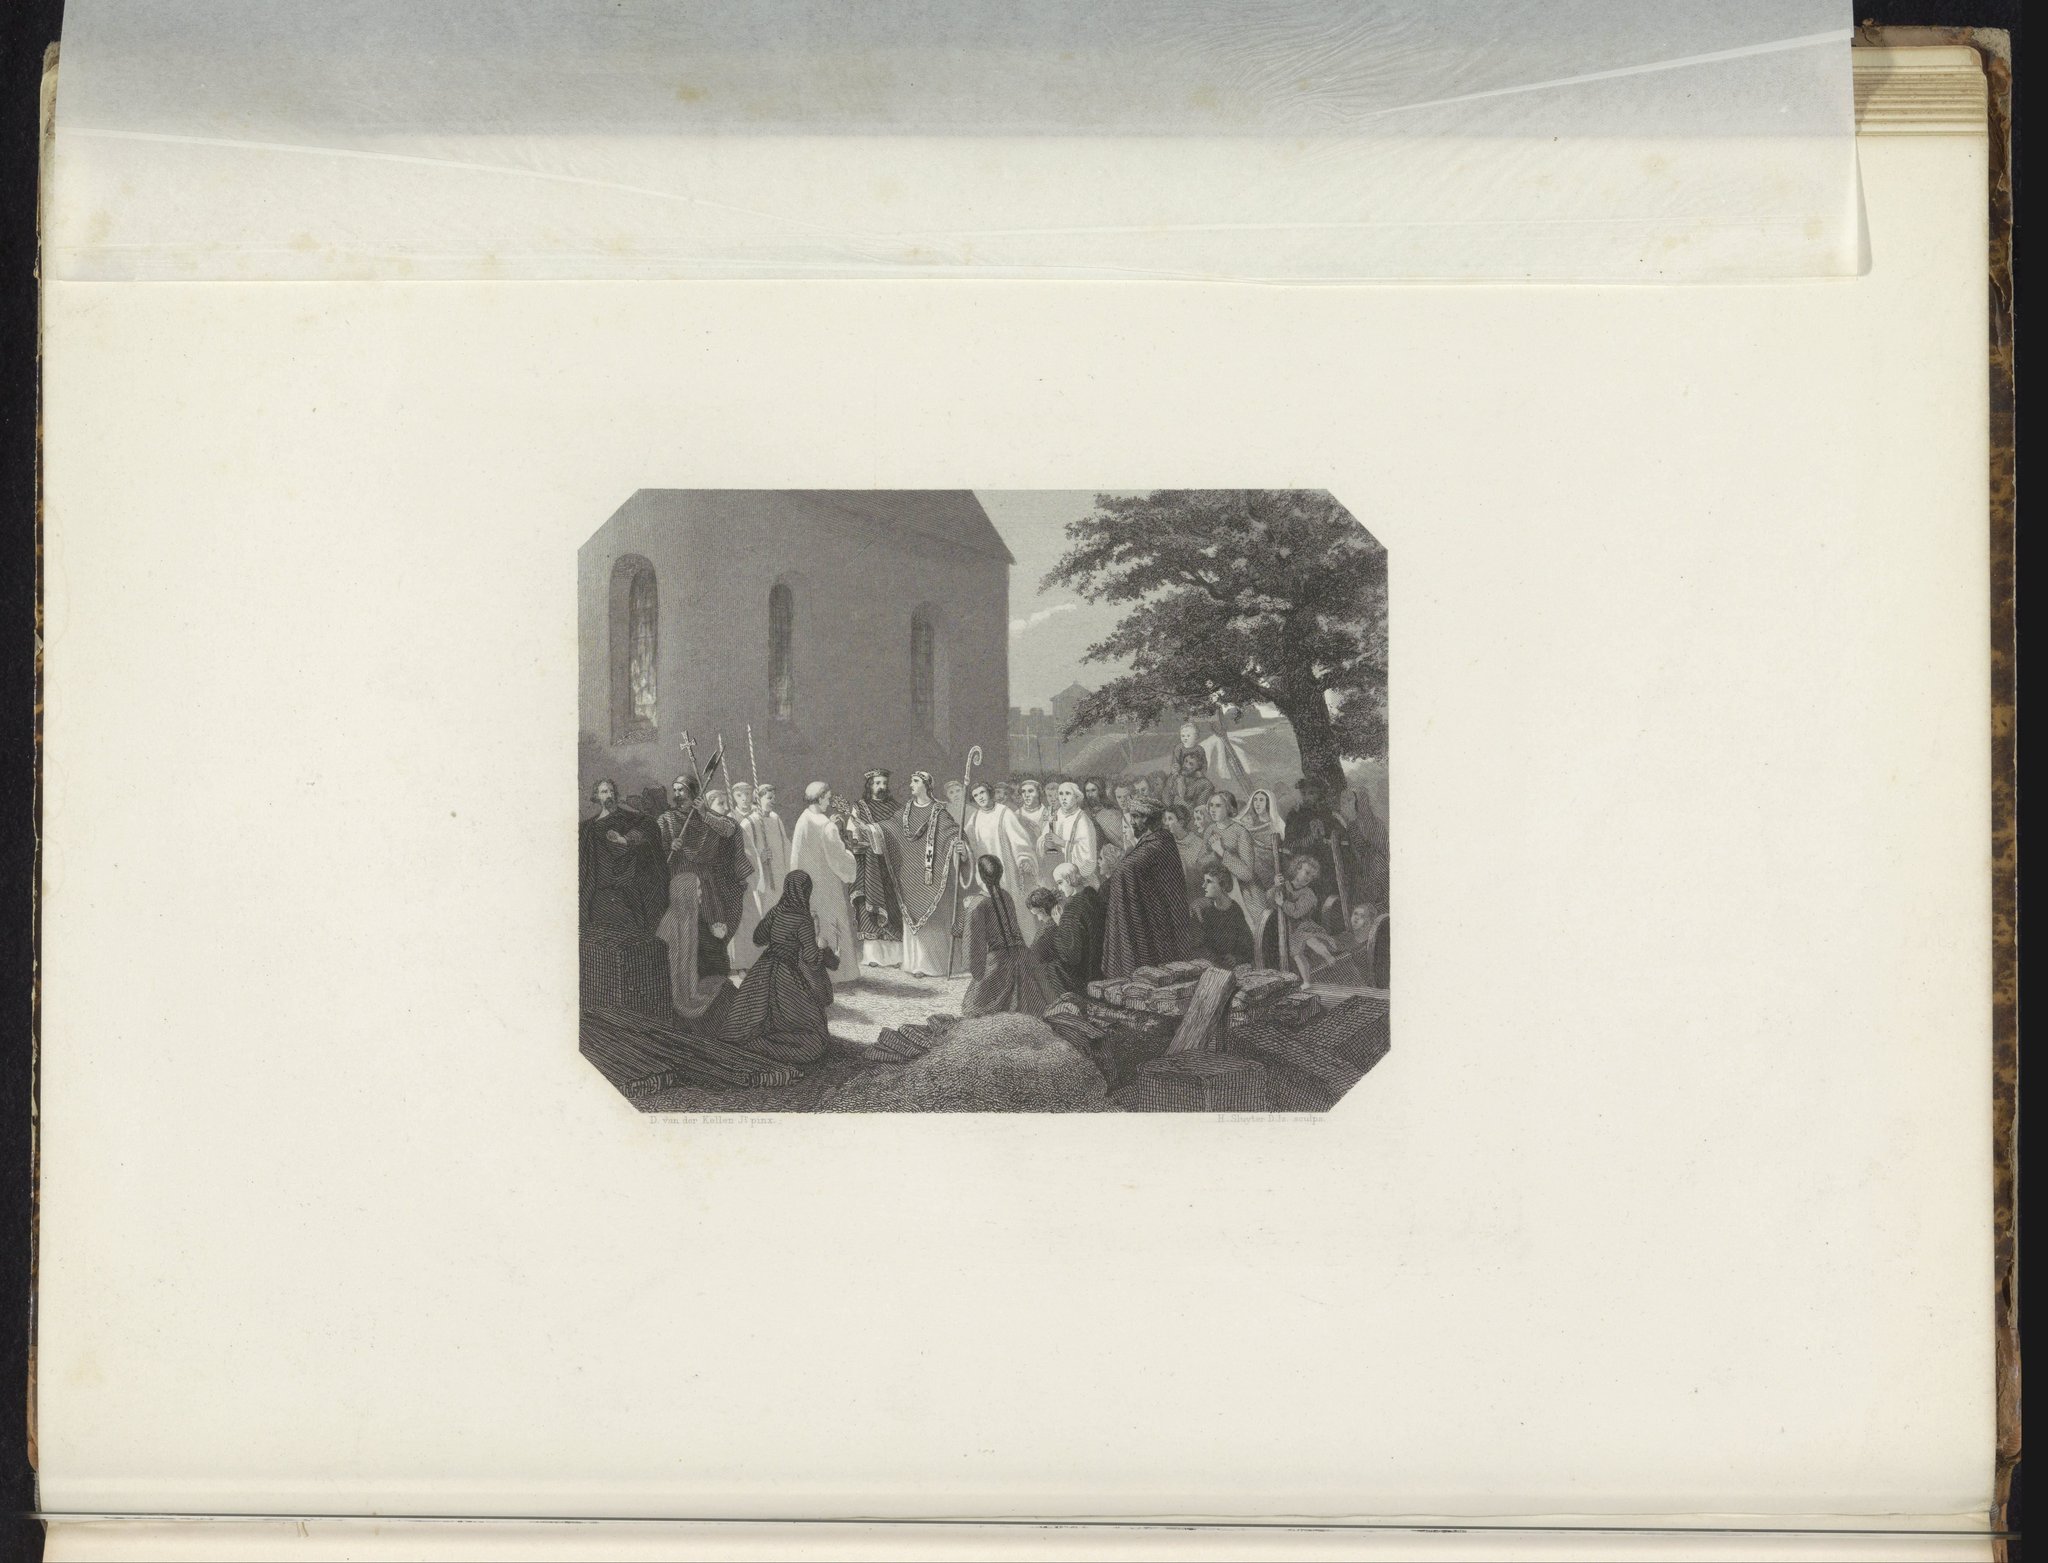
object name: history print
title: Wijding der St. Thomas-kerk te Utrecht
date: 1865-1870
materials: paper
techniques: engraving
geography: netherlands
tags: inauguration, consecration of person(s) ~ church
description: De wijding van de Sint-Thomaskerk te Utrecht, 7e eeuw. Een groep mensen verzameld buiten de kerk voor de ceremonie. Onderdeel van de groep staalgravures naar de schilderijen van de Historische Galerij der Maatschappij Arti et Amicitiae.